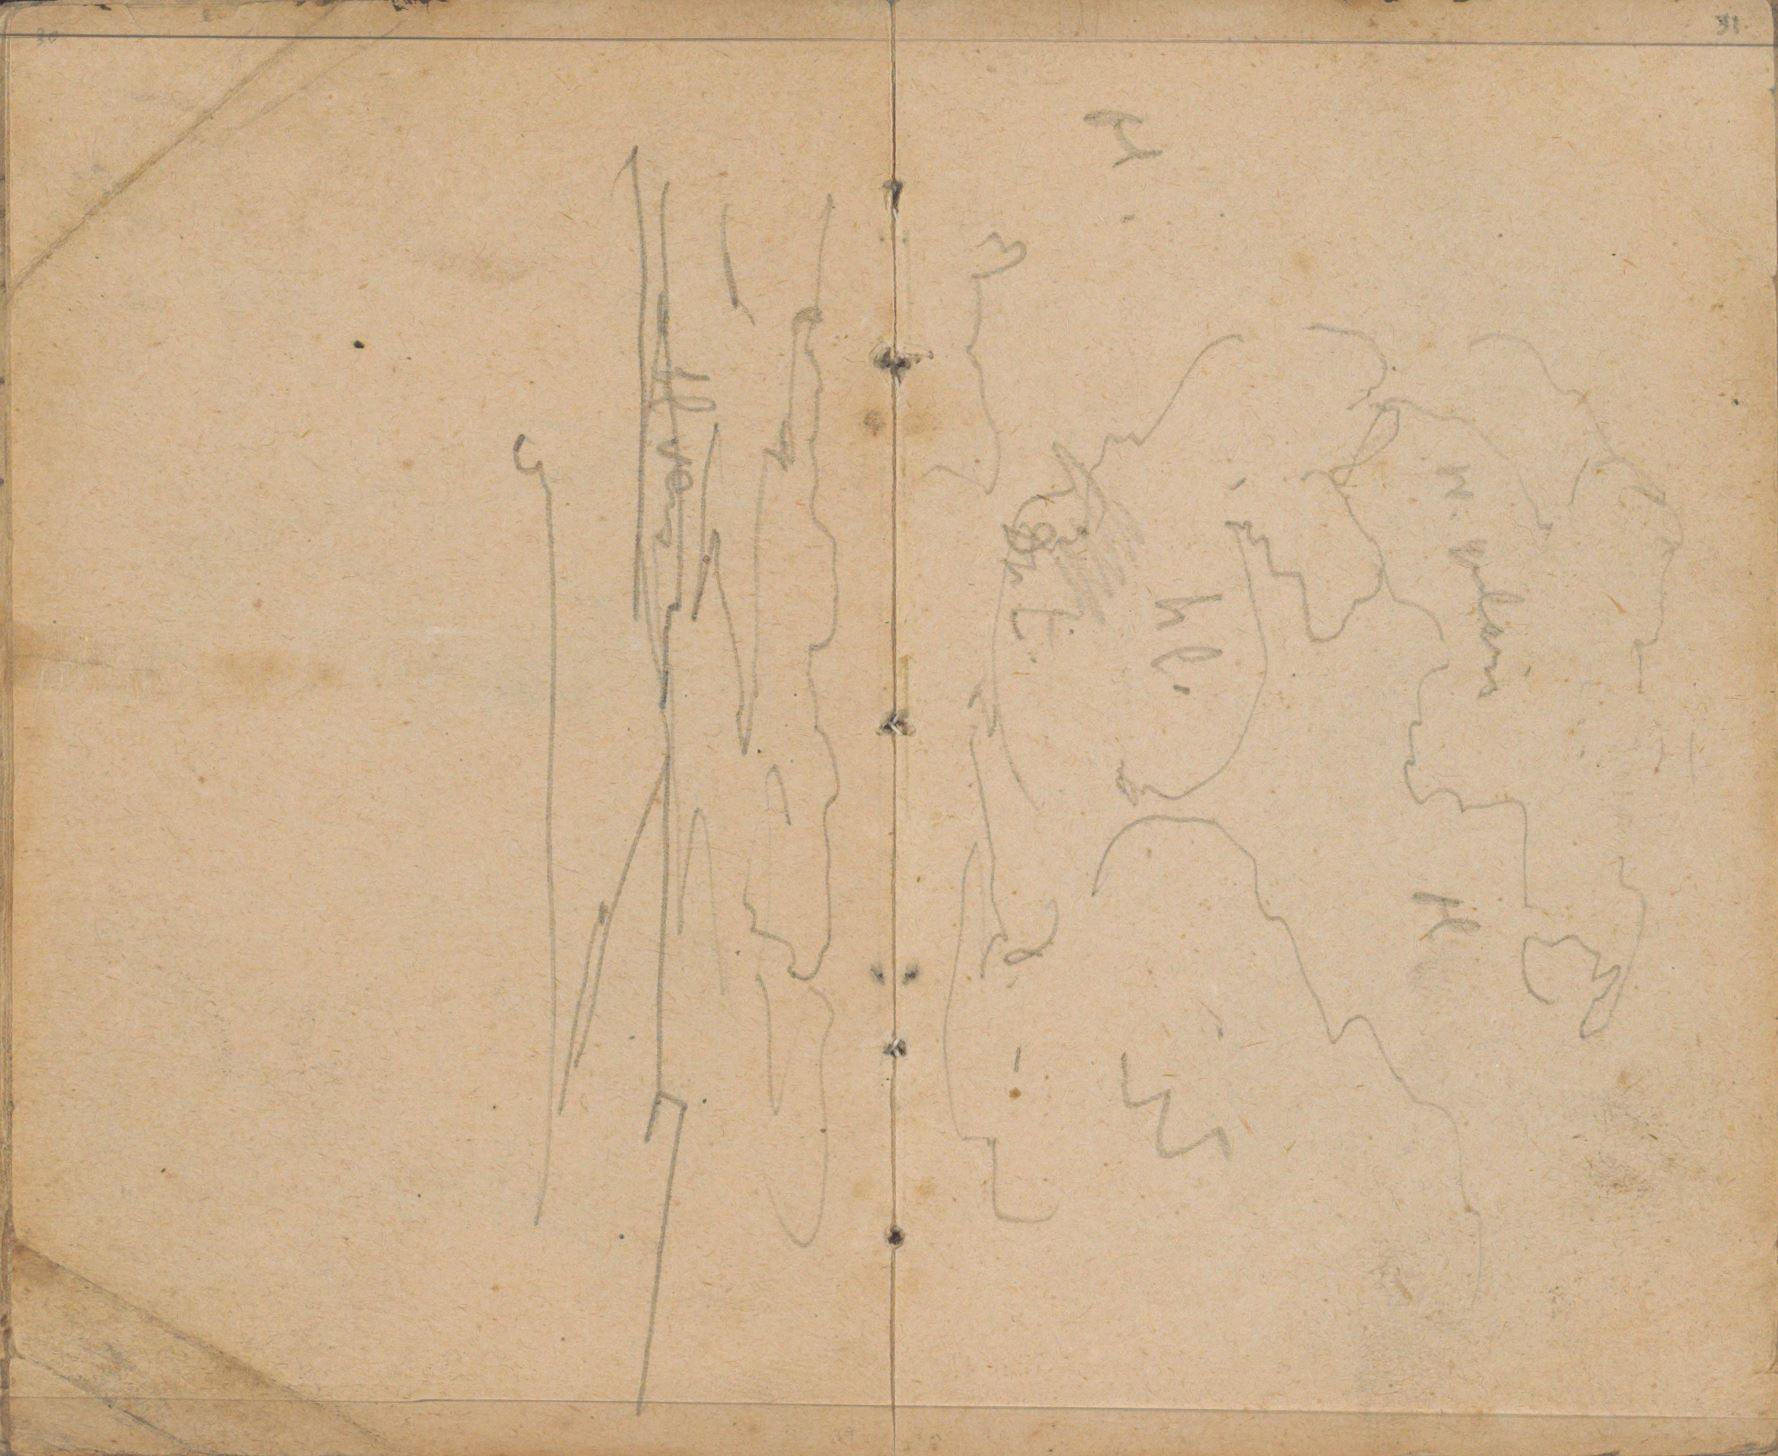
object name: sketchbook leaf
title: Vlak landschap met wolkenlucht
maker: george hendrik breitner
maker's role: draughtsman, painter, print maker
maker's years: 1857-1923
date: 1881-1883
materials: paper, pencil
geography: south holland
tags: landscapes, clouds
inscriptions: kleurnotitie, handgeschreven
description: Vlak landschap met wolkenlucht. Pagina 30 en pagina 31 uit een schetsboek met 43 bladen.